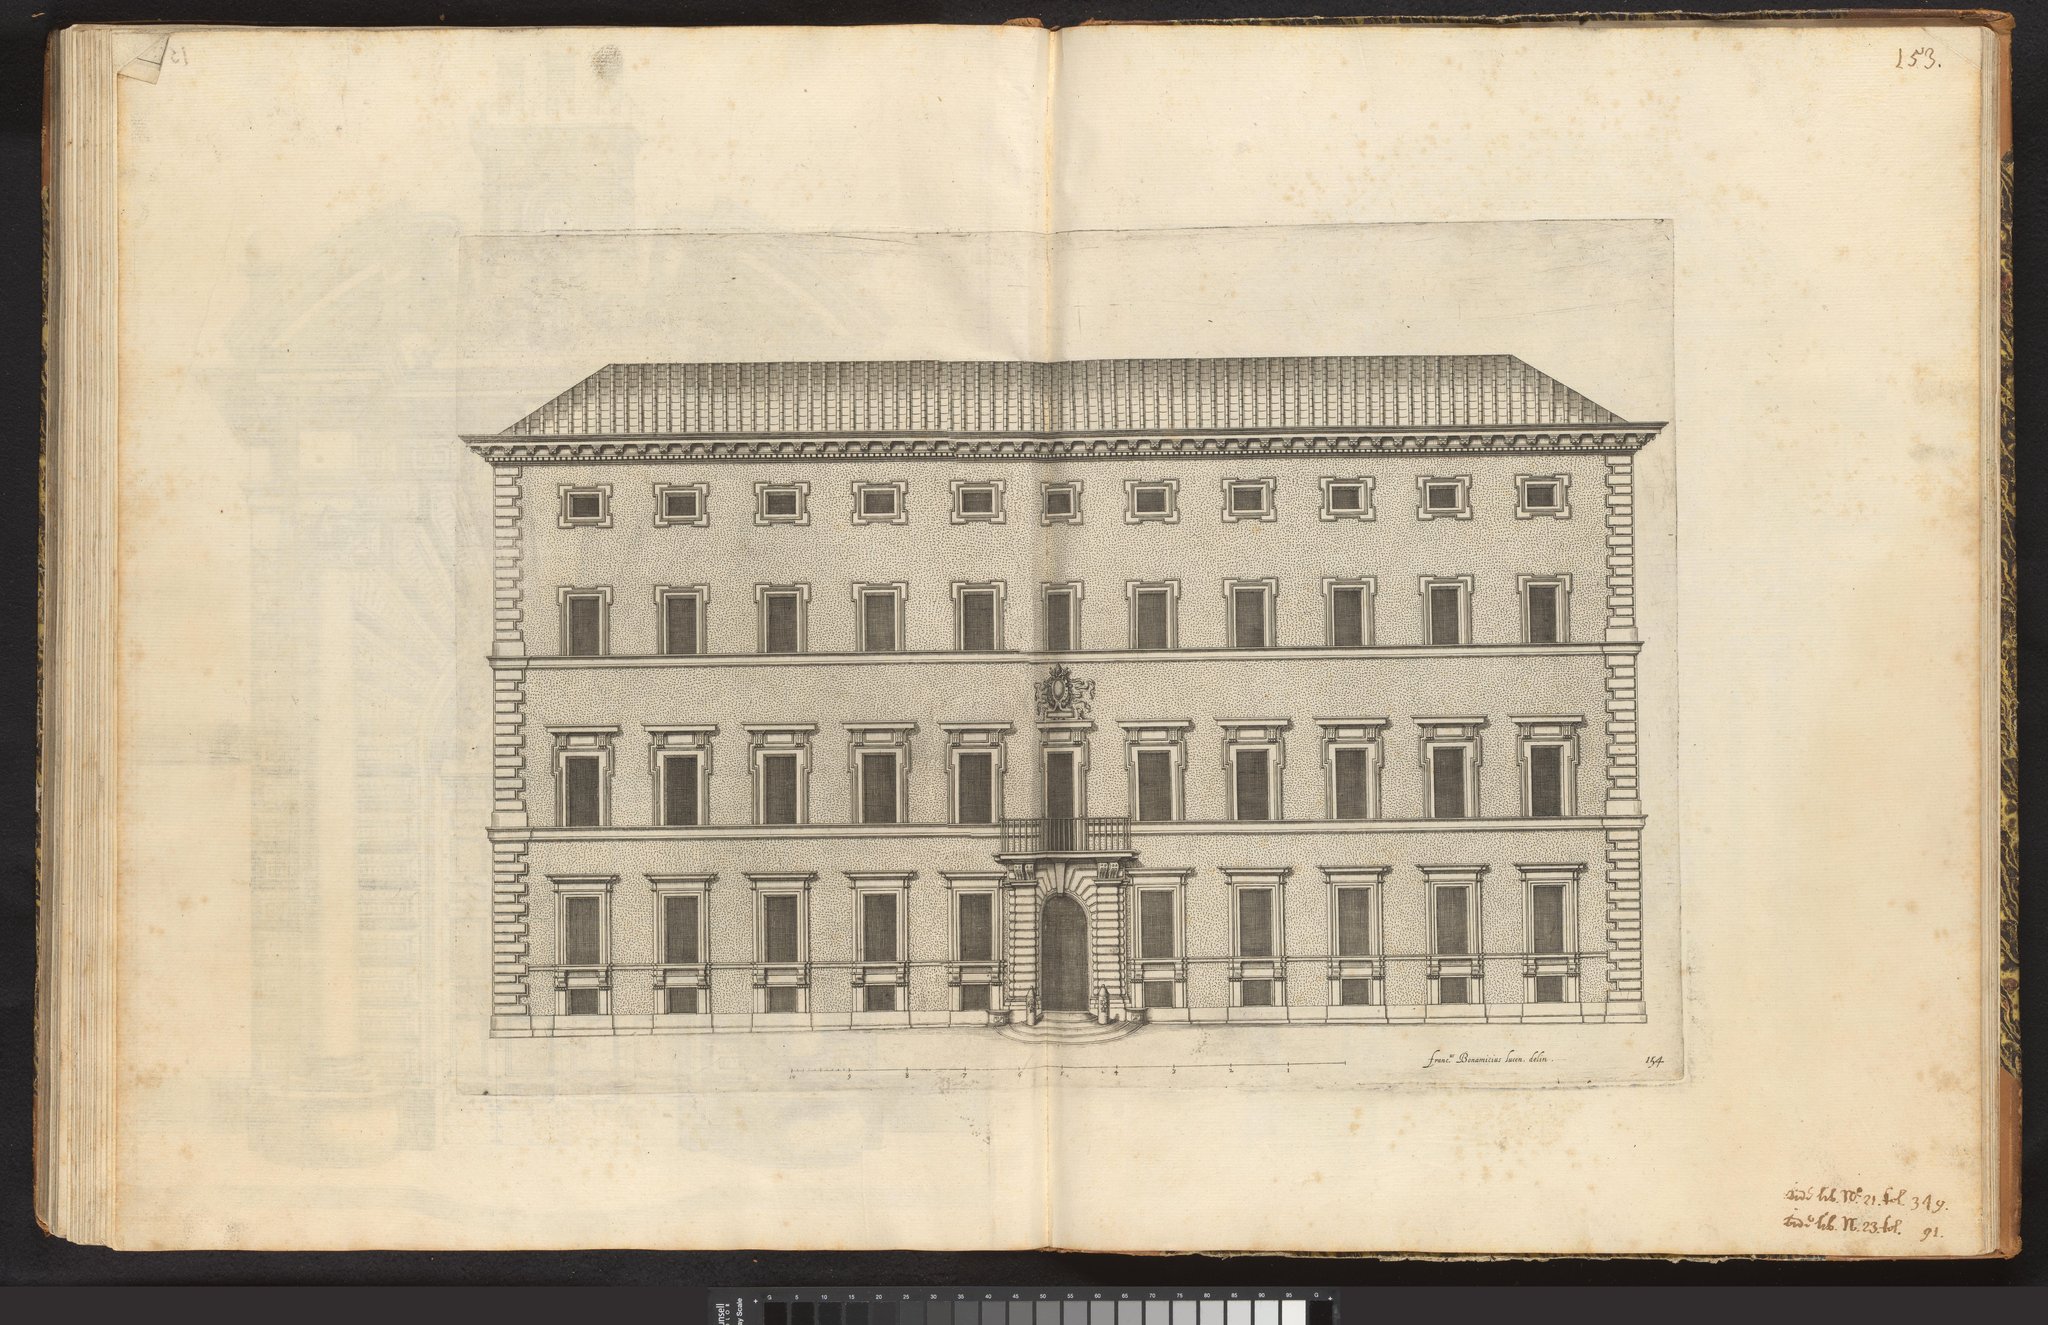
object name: album leaf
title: Vooraanzicht van het palazzo van Vincenzo Giustiniani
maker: matthäus greuter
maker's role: print maker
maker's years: 1564-1638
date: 1636-1647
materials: paper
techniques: engraving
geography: rome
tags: piece of sculpture, reproduction of a piece of sculpture, civic architecture; edifices; dwellings, rome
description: Vooraanzicht van het palazzo van Vincenzo Giustiniani te Rome. Prent maakt deel uit van een album met een serie prenten naar de sculpturen in de verzameling in de Galleria Giustiniani te Rome.